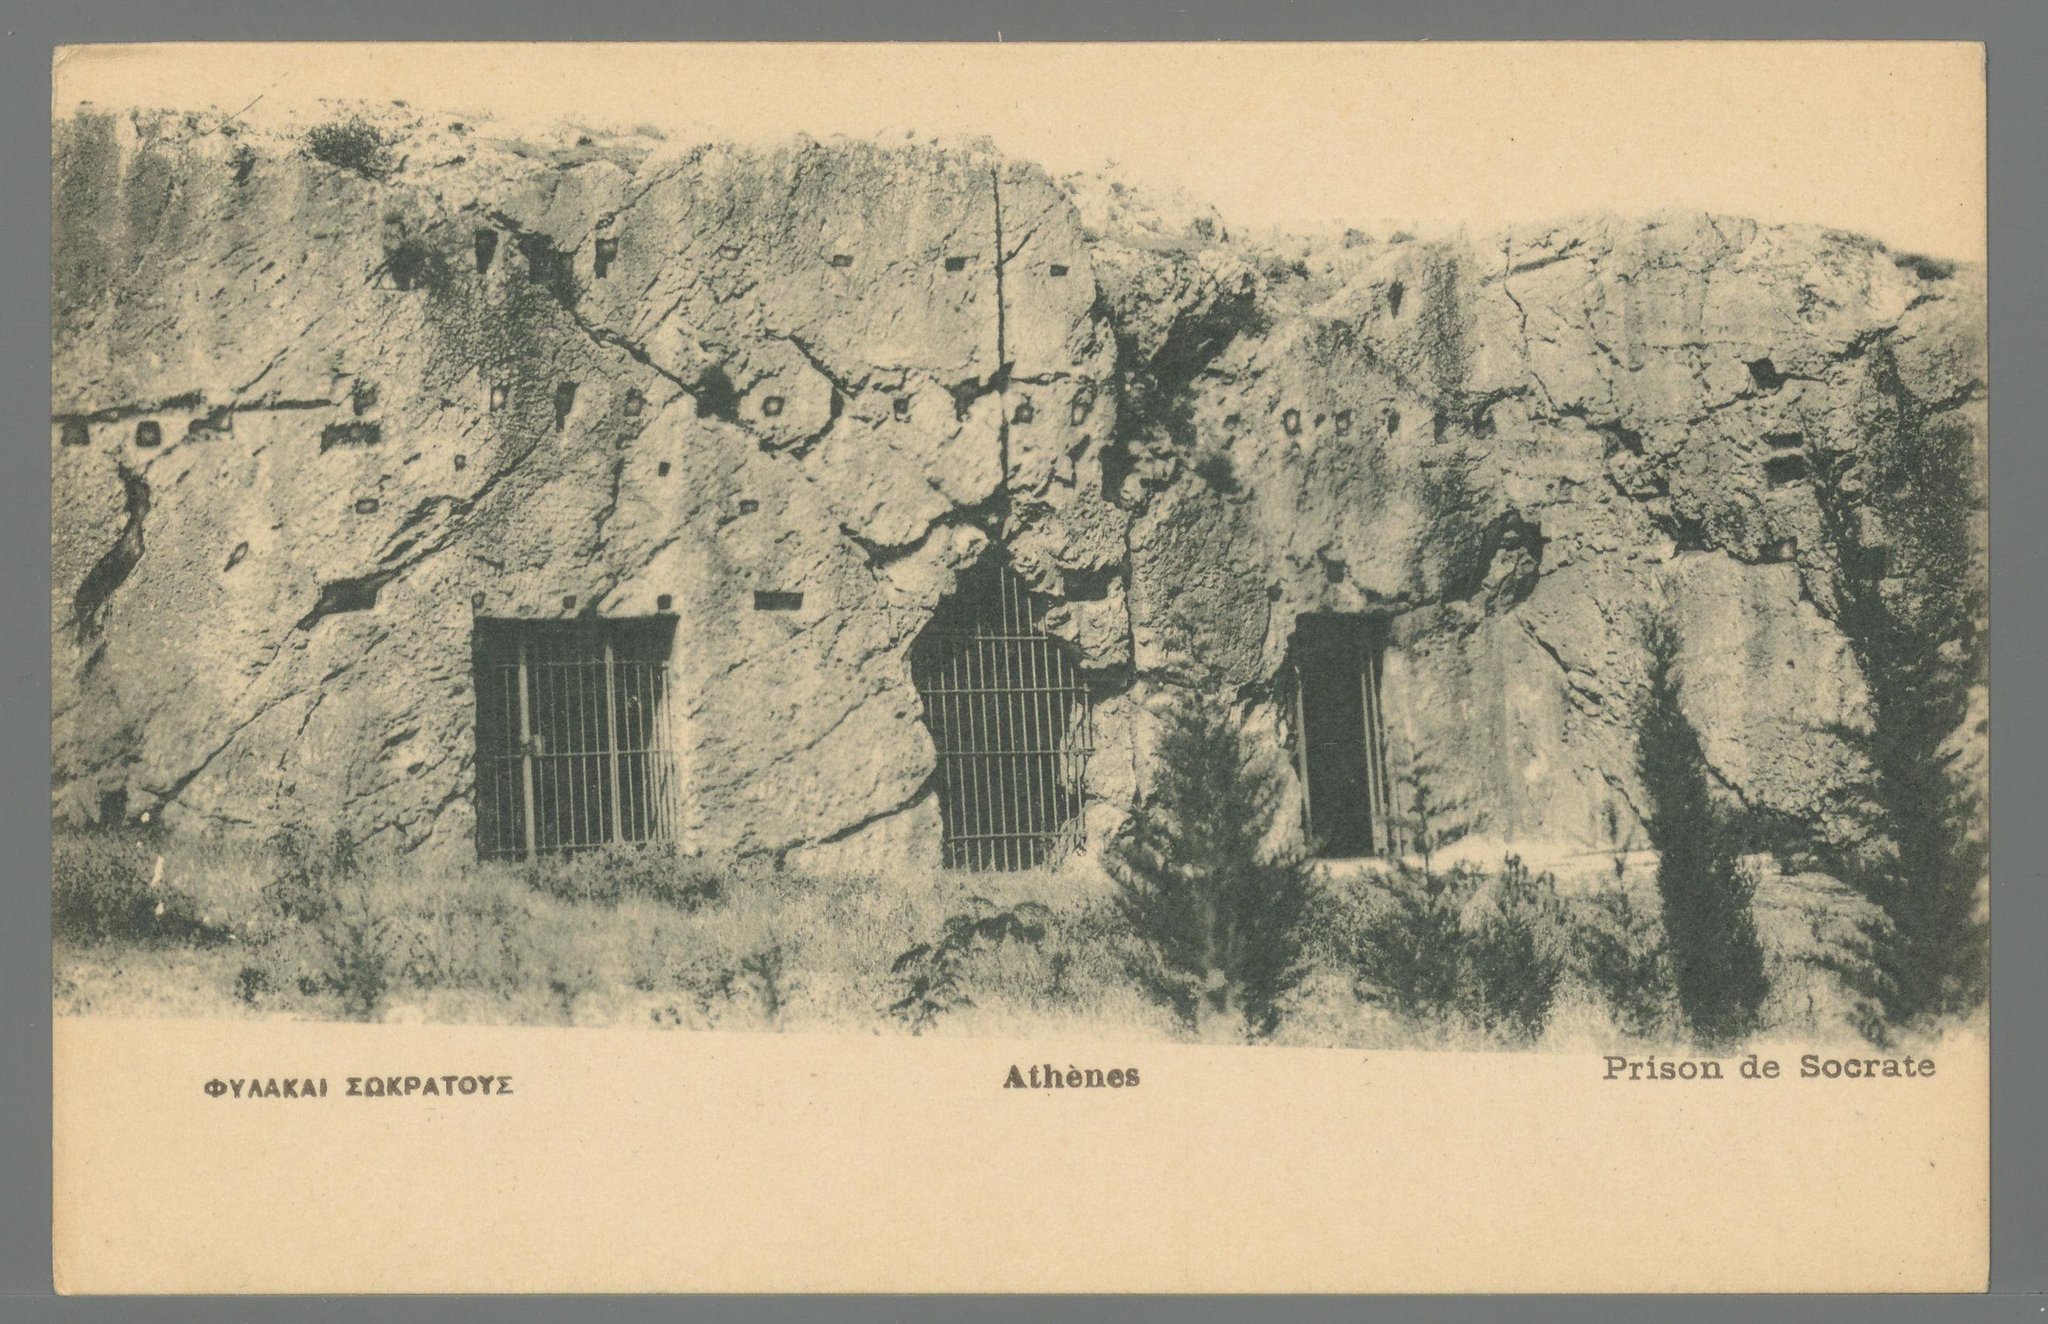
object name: ansichtkaart, prentbriefkaart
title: Athènes. Prison de Socrate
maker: Anonymous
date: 1906-1930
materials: cardboard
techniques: photograph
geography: athens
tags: prison, jail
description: Voor de Franse titel staat de titel in het Grieks.